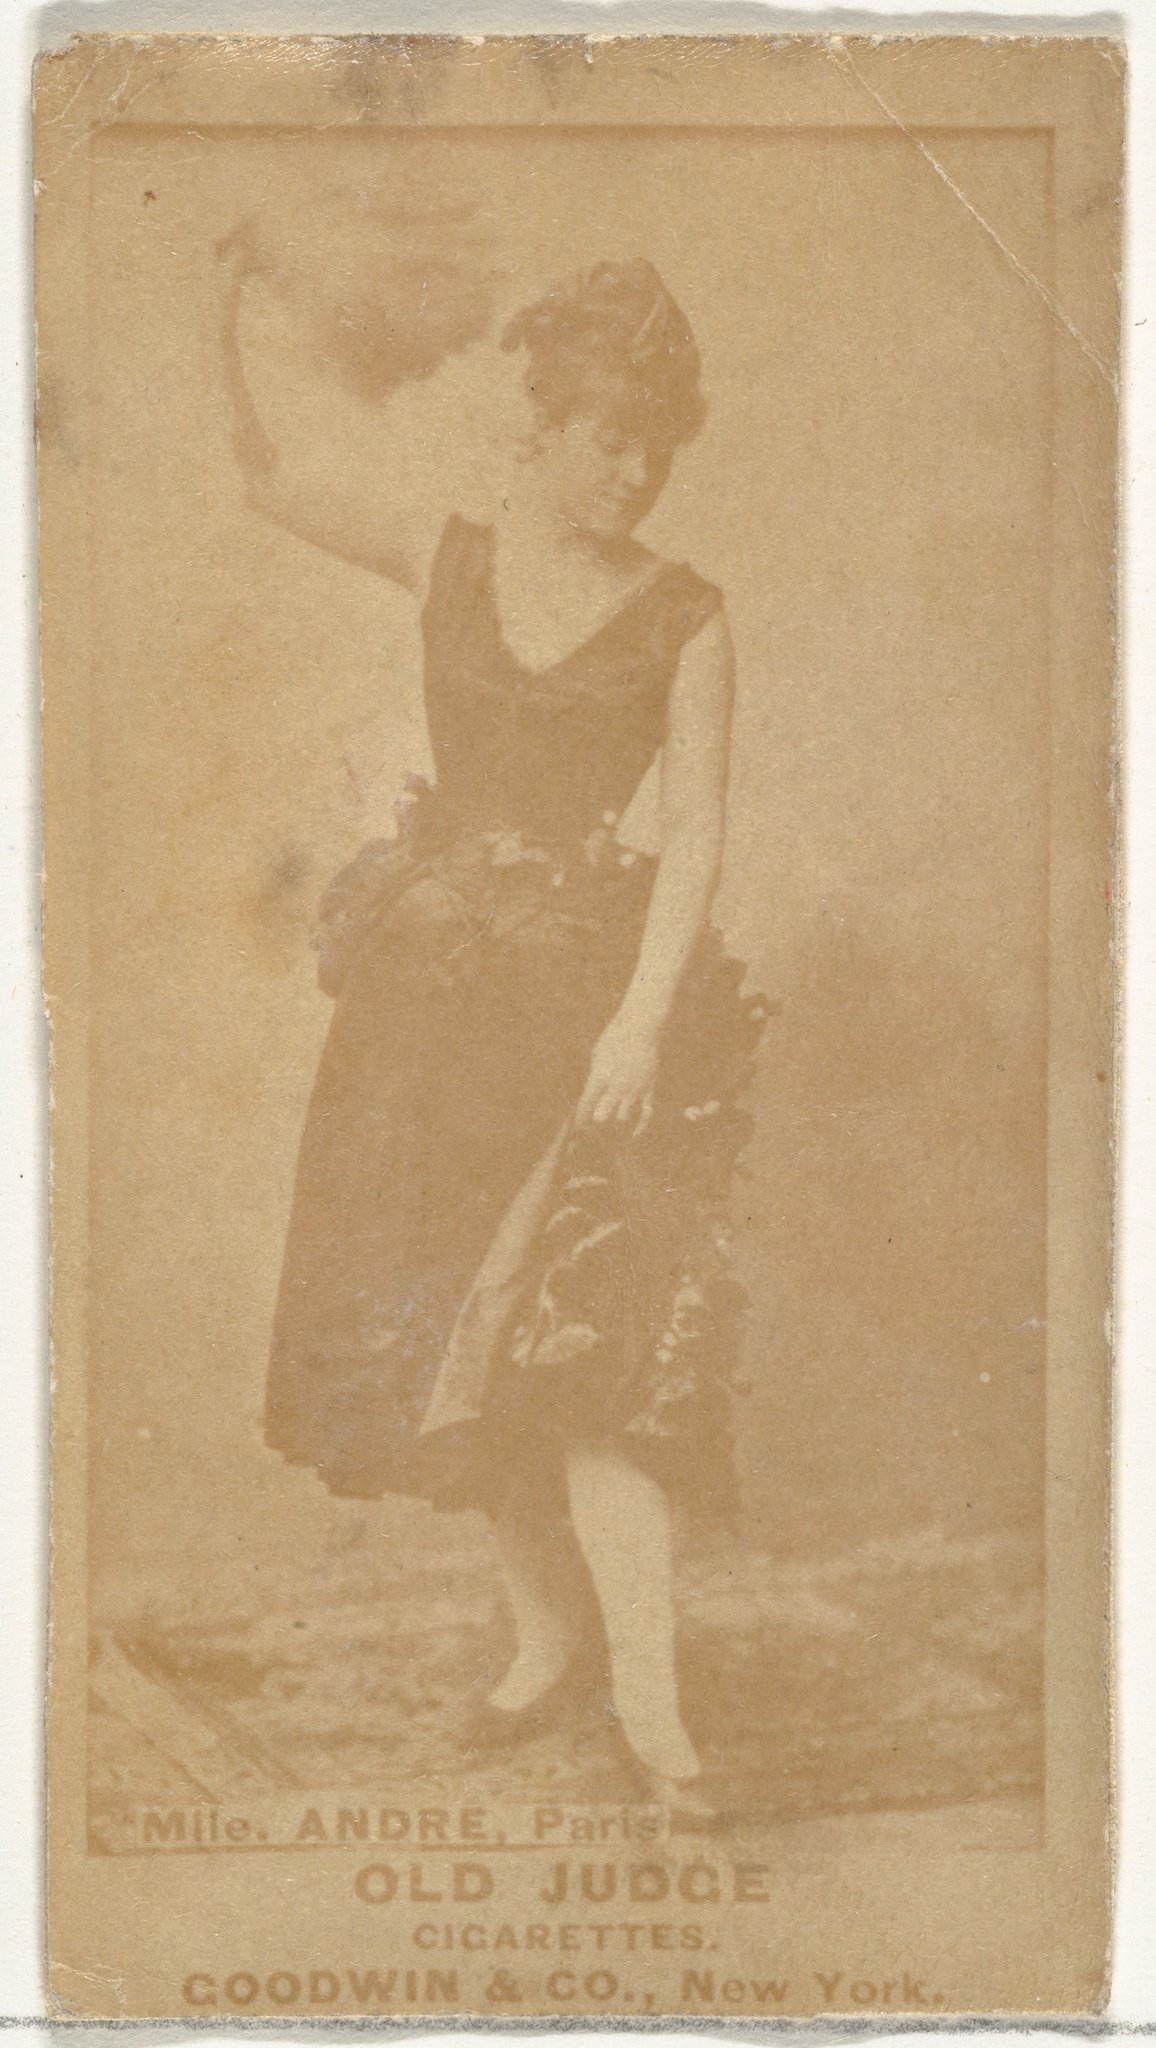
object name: photograph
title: Mlle. Andre, Paris, from the Actors and Actresses series (N171) for Old Judge Cigarettes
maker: goodwin & company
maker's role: publisher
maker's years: 1850-1950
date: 1886-1890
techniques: albumen silver print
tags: portraits,women,actresses